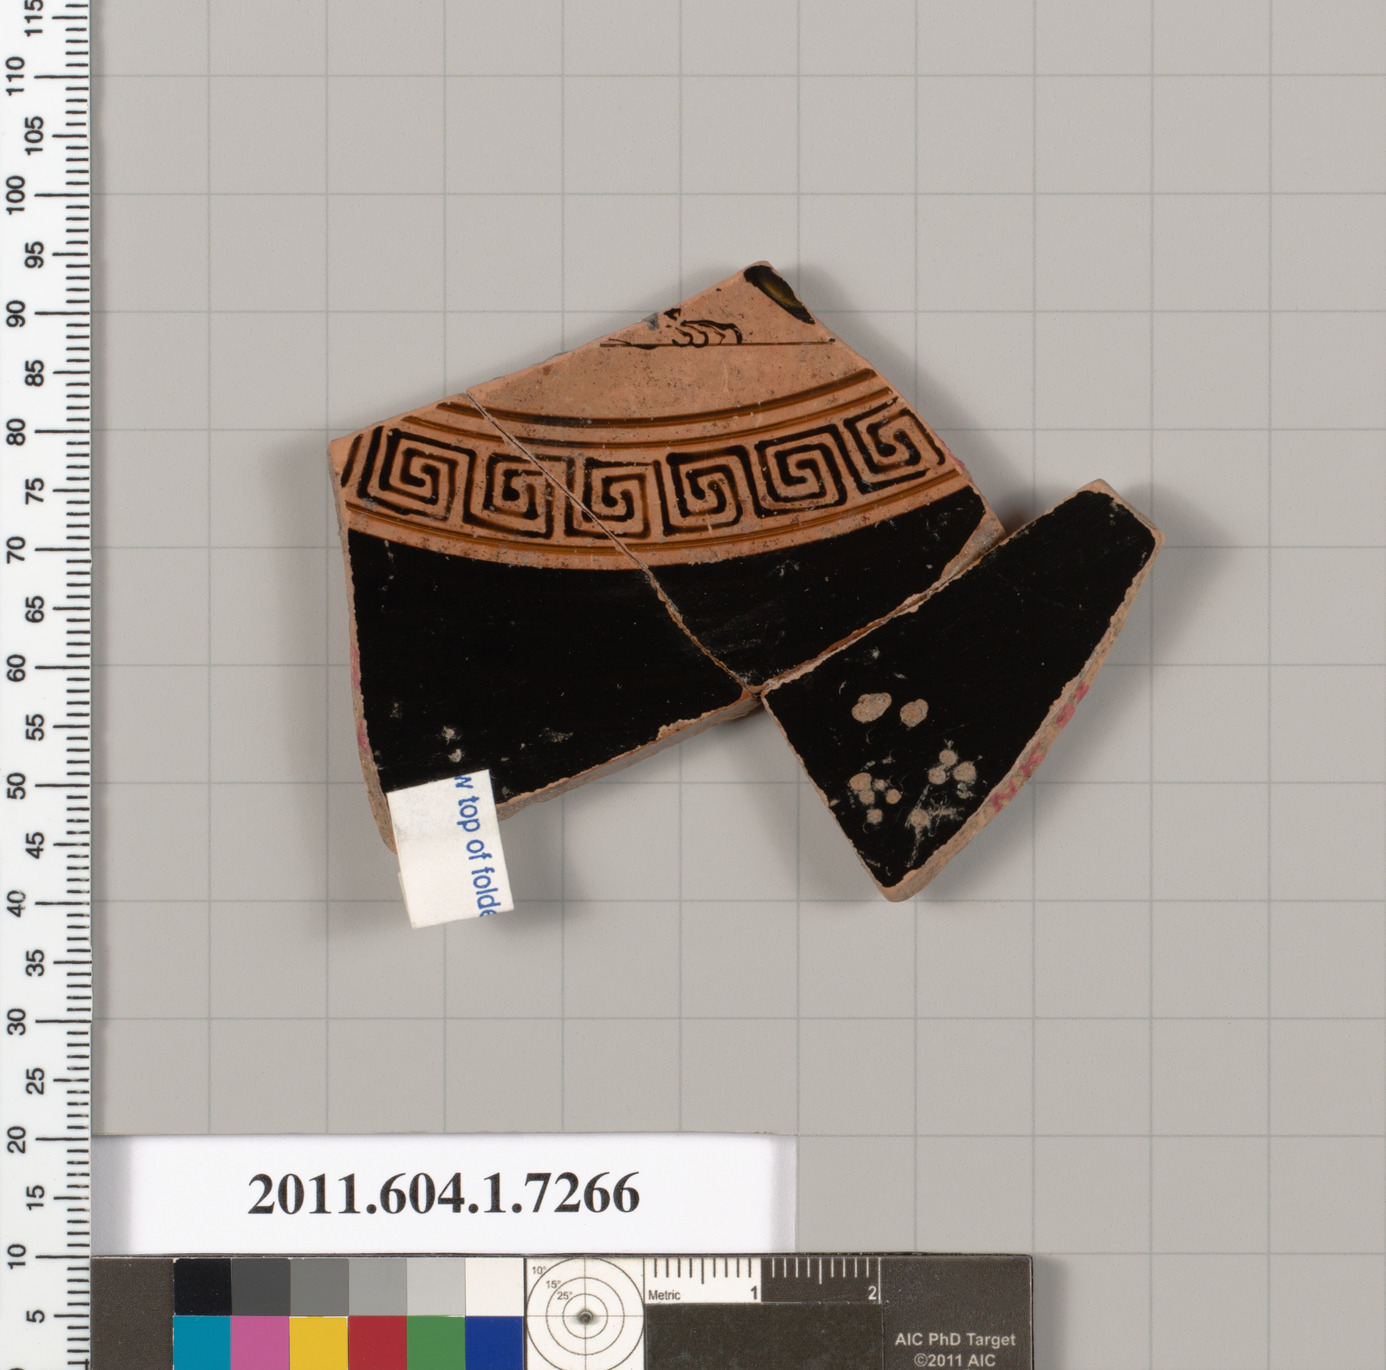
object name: kylix fragment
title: Terracotta fragment of a kylix (drinking cup)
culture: greek, attic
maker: makron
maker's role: artist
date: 500-480 BCE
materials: terracotta